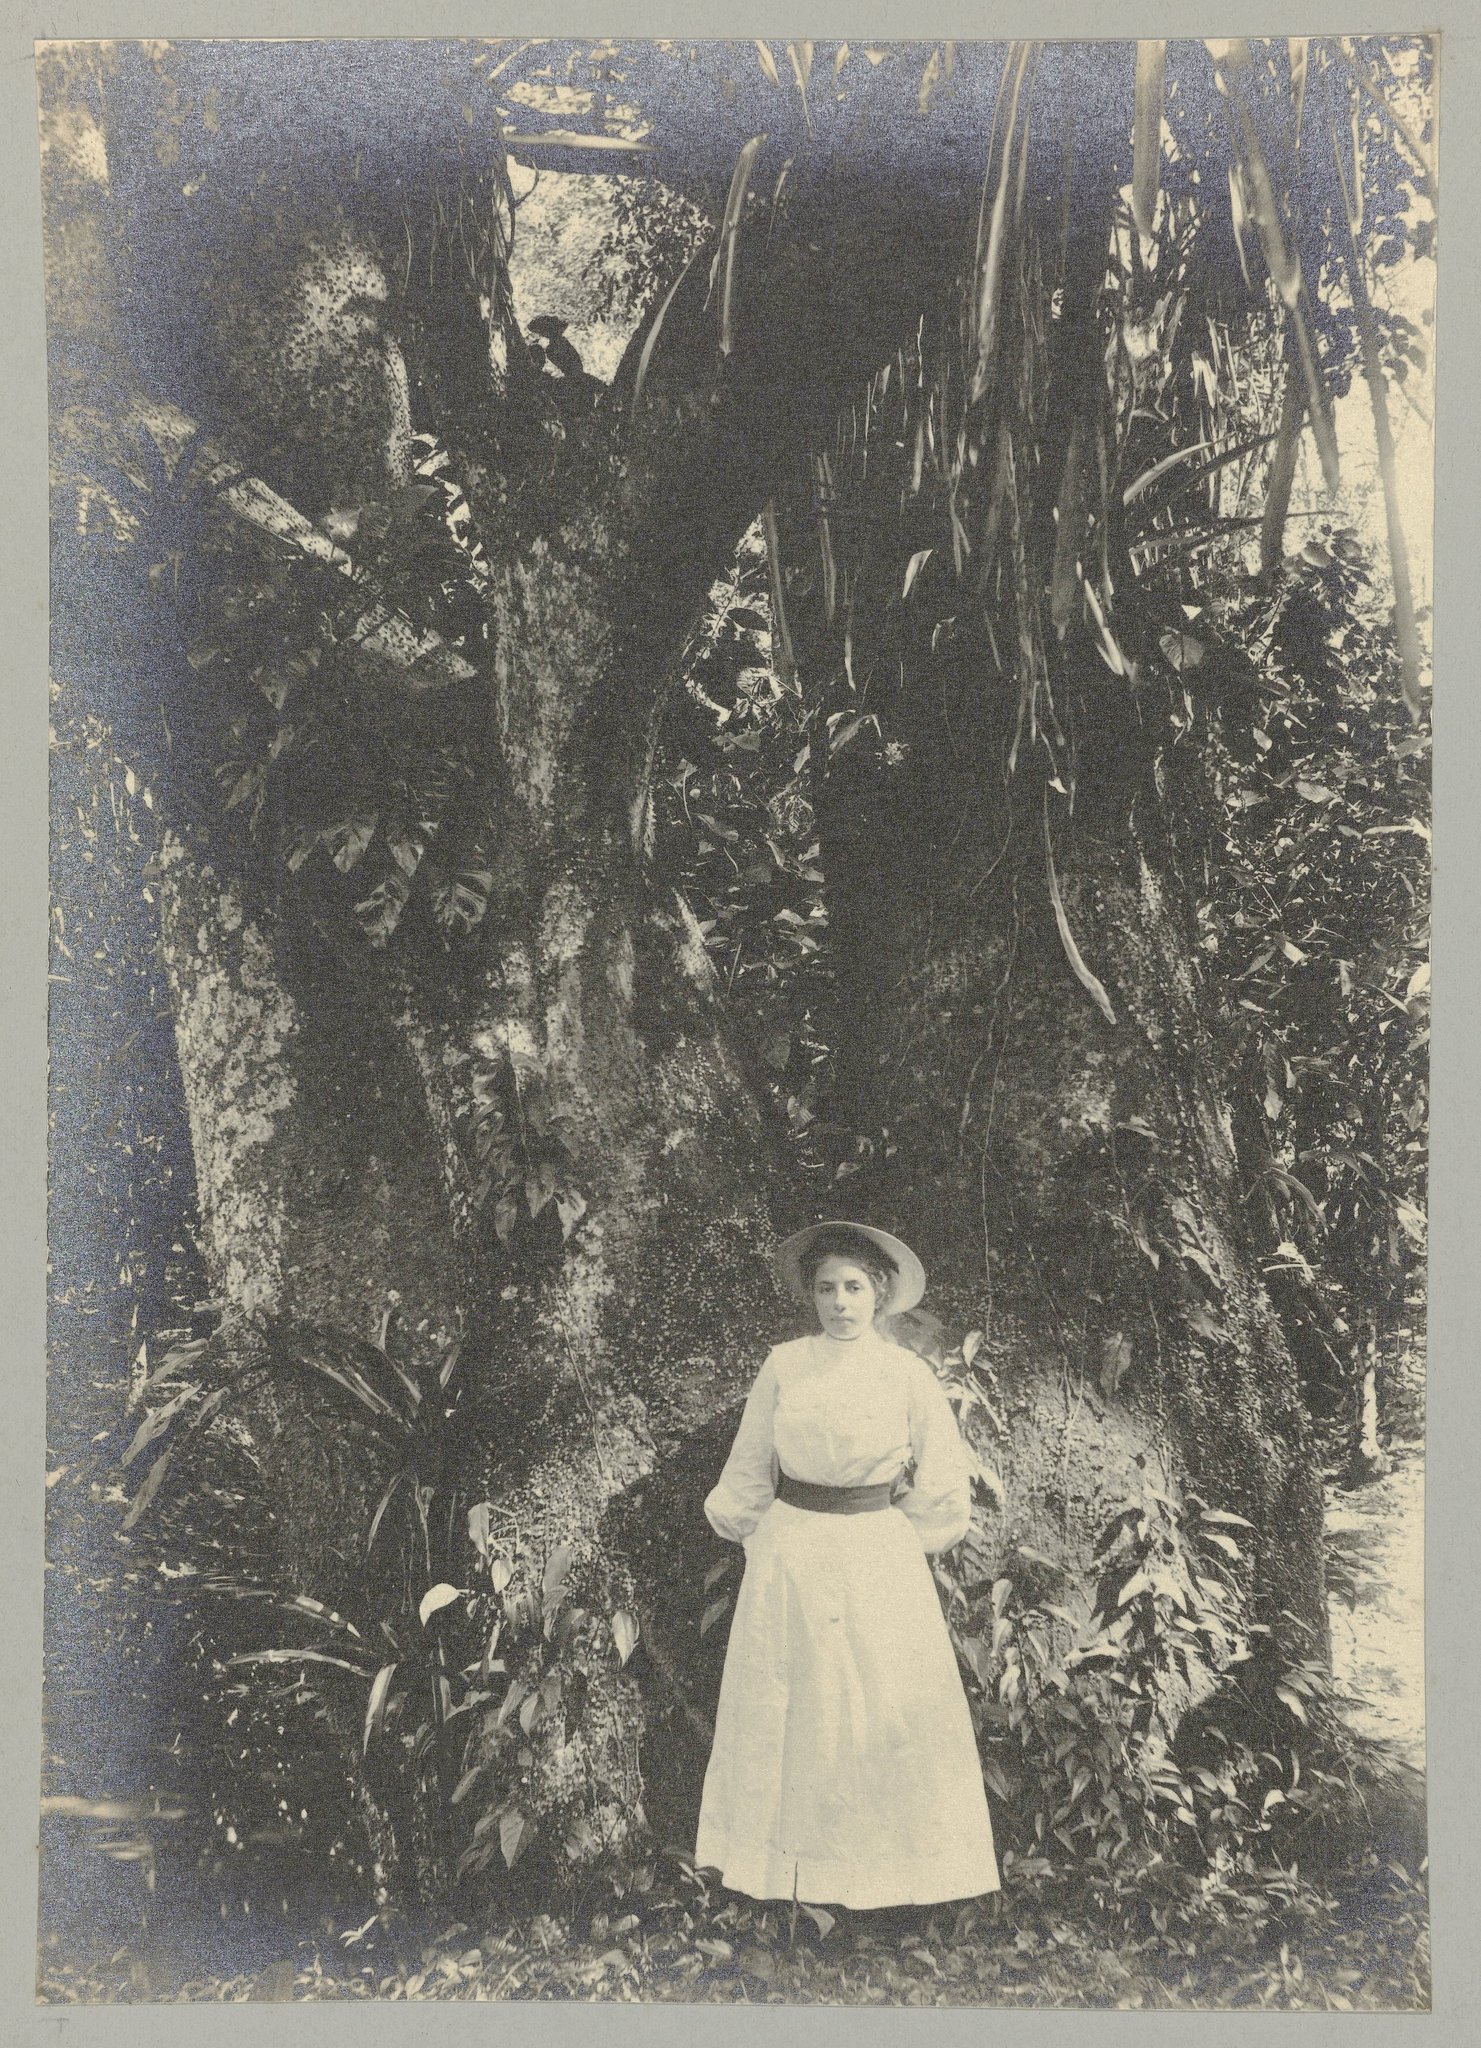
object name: photograph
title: To bij woudreus op Tourtonne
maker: hendrik doijer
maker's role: engineer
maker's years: 1863-1925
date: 1903-1910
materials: photographic support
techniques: gelatin silver print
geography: suriname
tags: suriname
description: Een Nederlandse jonge vrouw genaamd To poserend voor een grote boom op de Plantage Tourtonne. Onderdeel van het fotoalbum Souvenir de Voyage (deel 4), over het leven van de familie Doijer in en rond de plantage Ma Retraite in Suriname in de jaren 1903-1910.